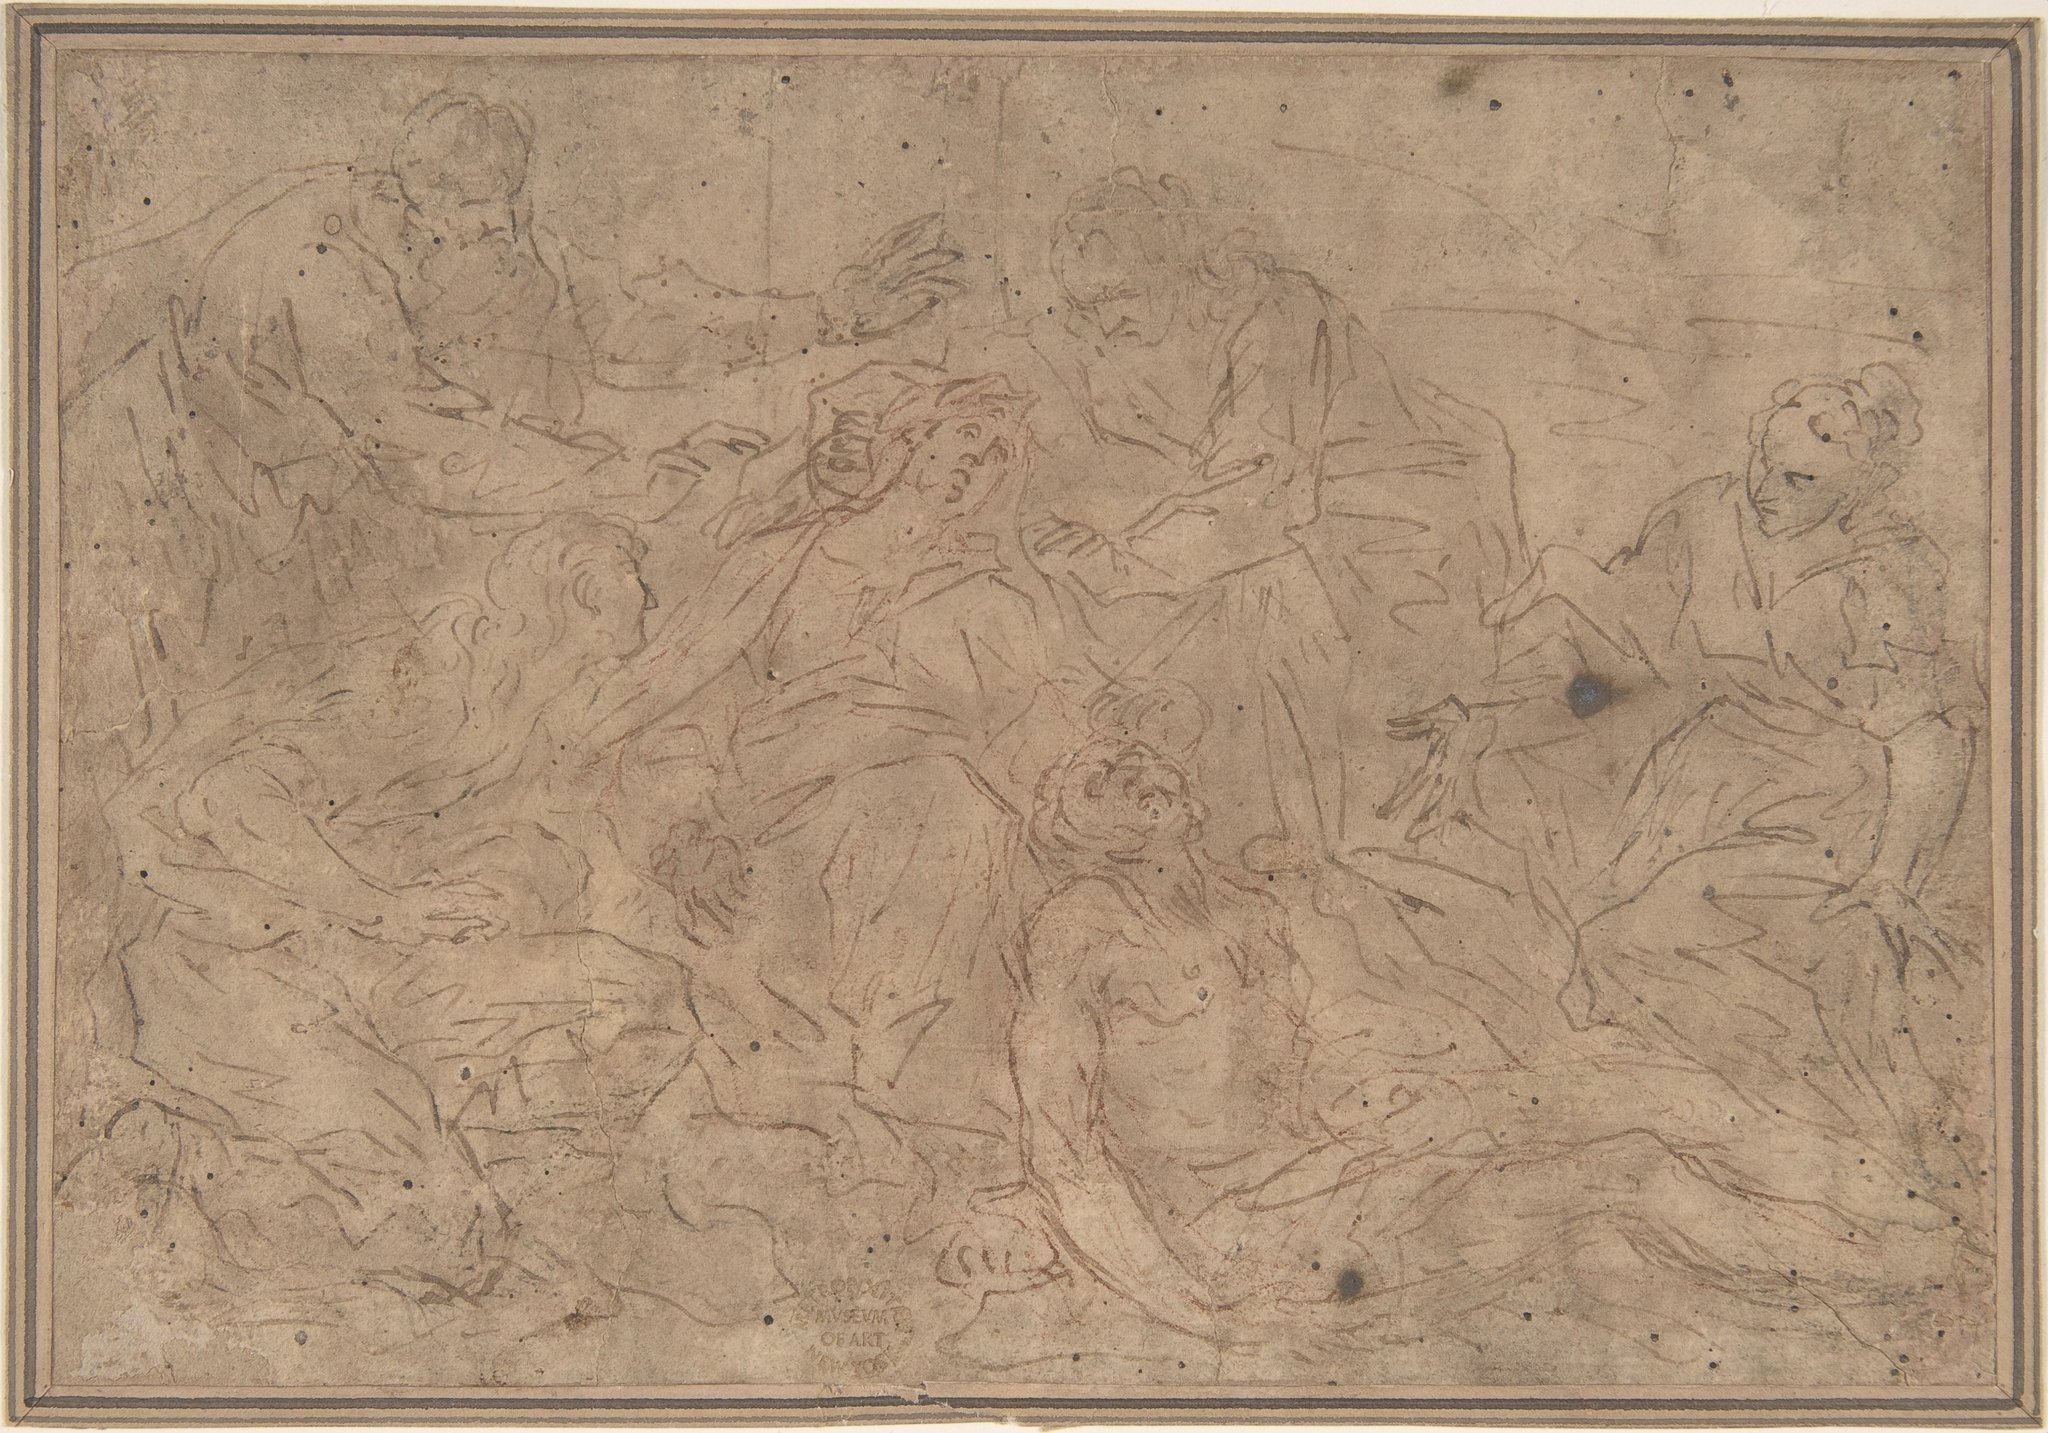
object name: drawing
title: Lamentation over the Dead Christ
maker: anonymous, italian, roman-bolognese, 17th century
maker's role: artist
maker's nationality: italian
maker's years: 1600-1700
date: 1601-1700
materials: chalk, ink, paper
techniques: brush, pen, wash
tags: men,women,christ,lamentation